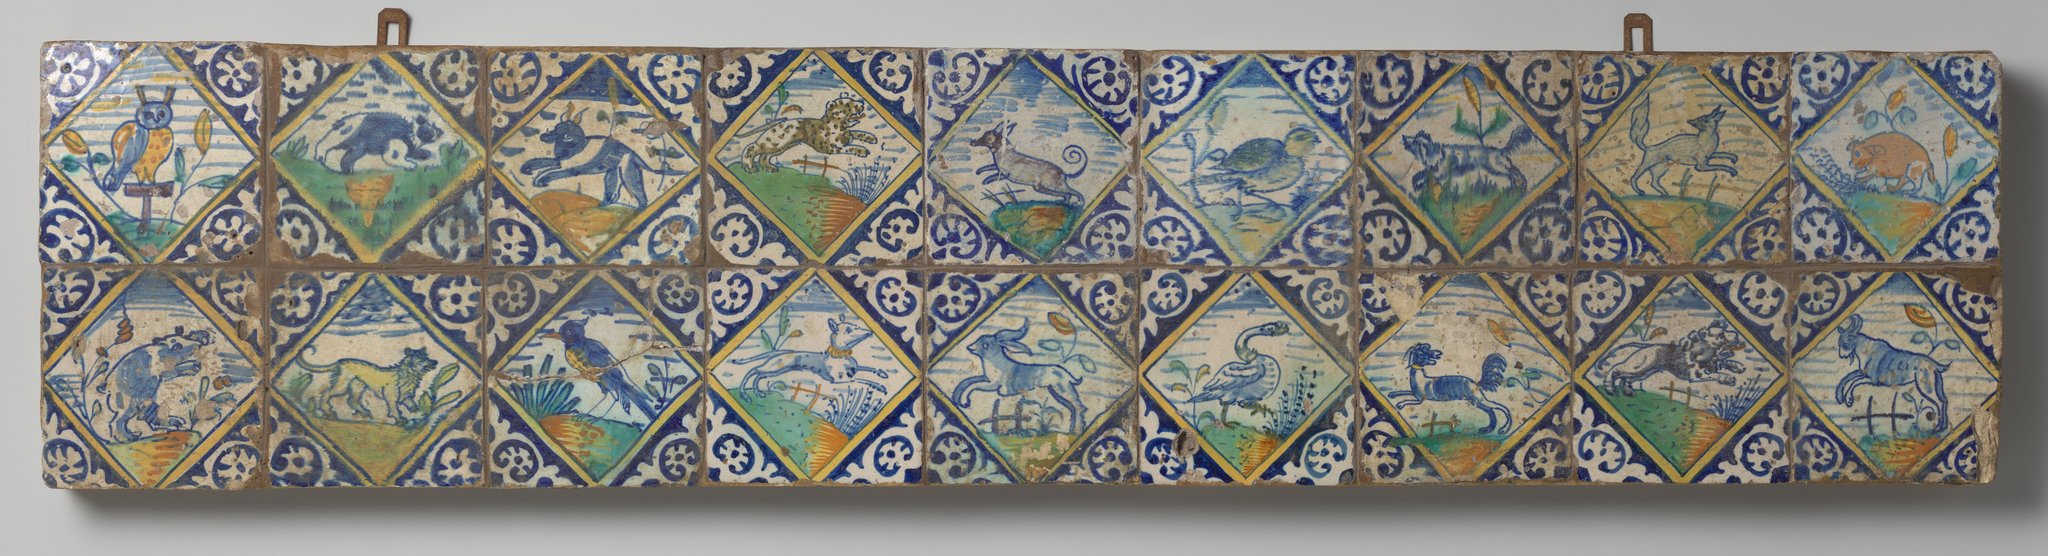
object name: diertegel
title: Veld van achttien tegels met dieren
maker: Anonymous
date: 1580-1625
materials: earthenware, glaze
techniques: maiolica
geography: netherlands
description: Veld van achttien tegels (2 x 9) elk met een veelkleurig (blauw, oranje, geel, groen, paars en bruingroen) geschilderd dier binnen een kwadraat omlijsting. In de hoeken, vultechniek ornament.